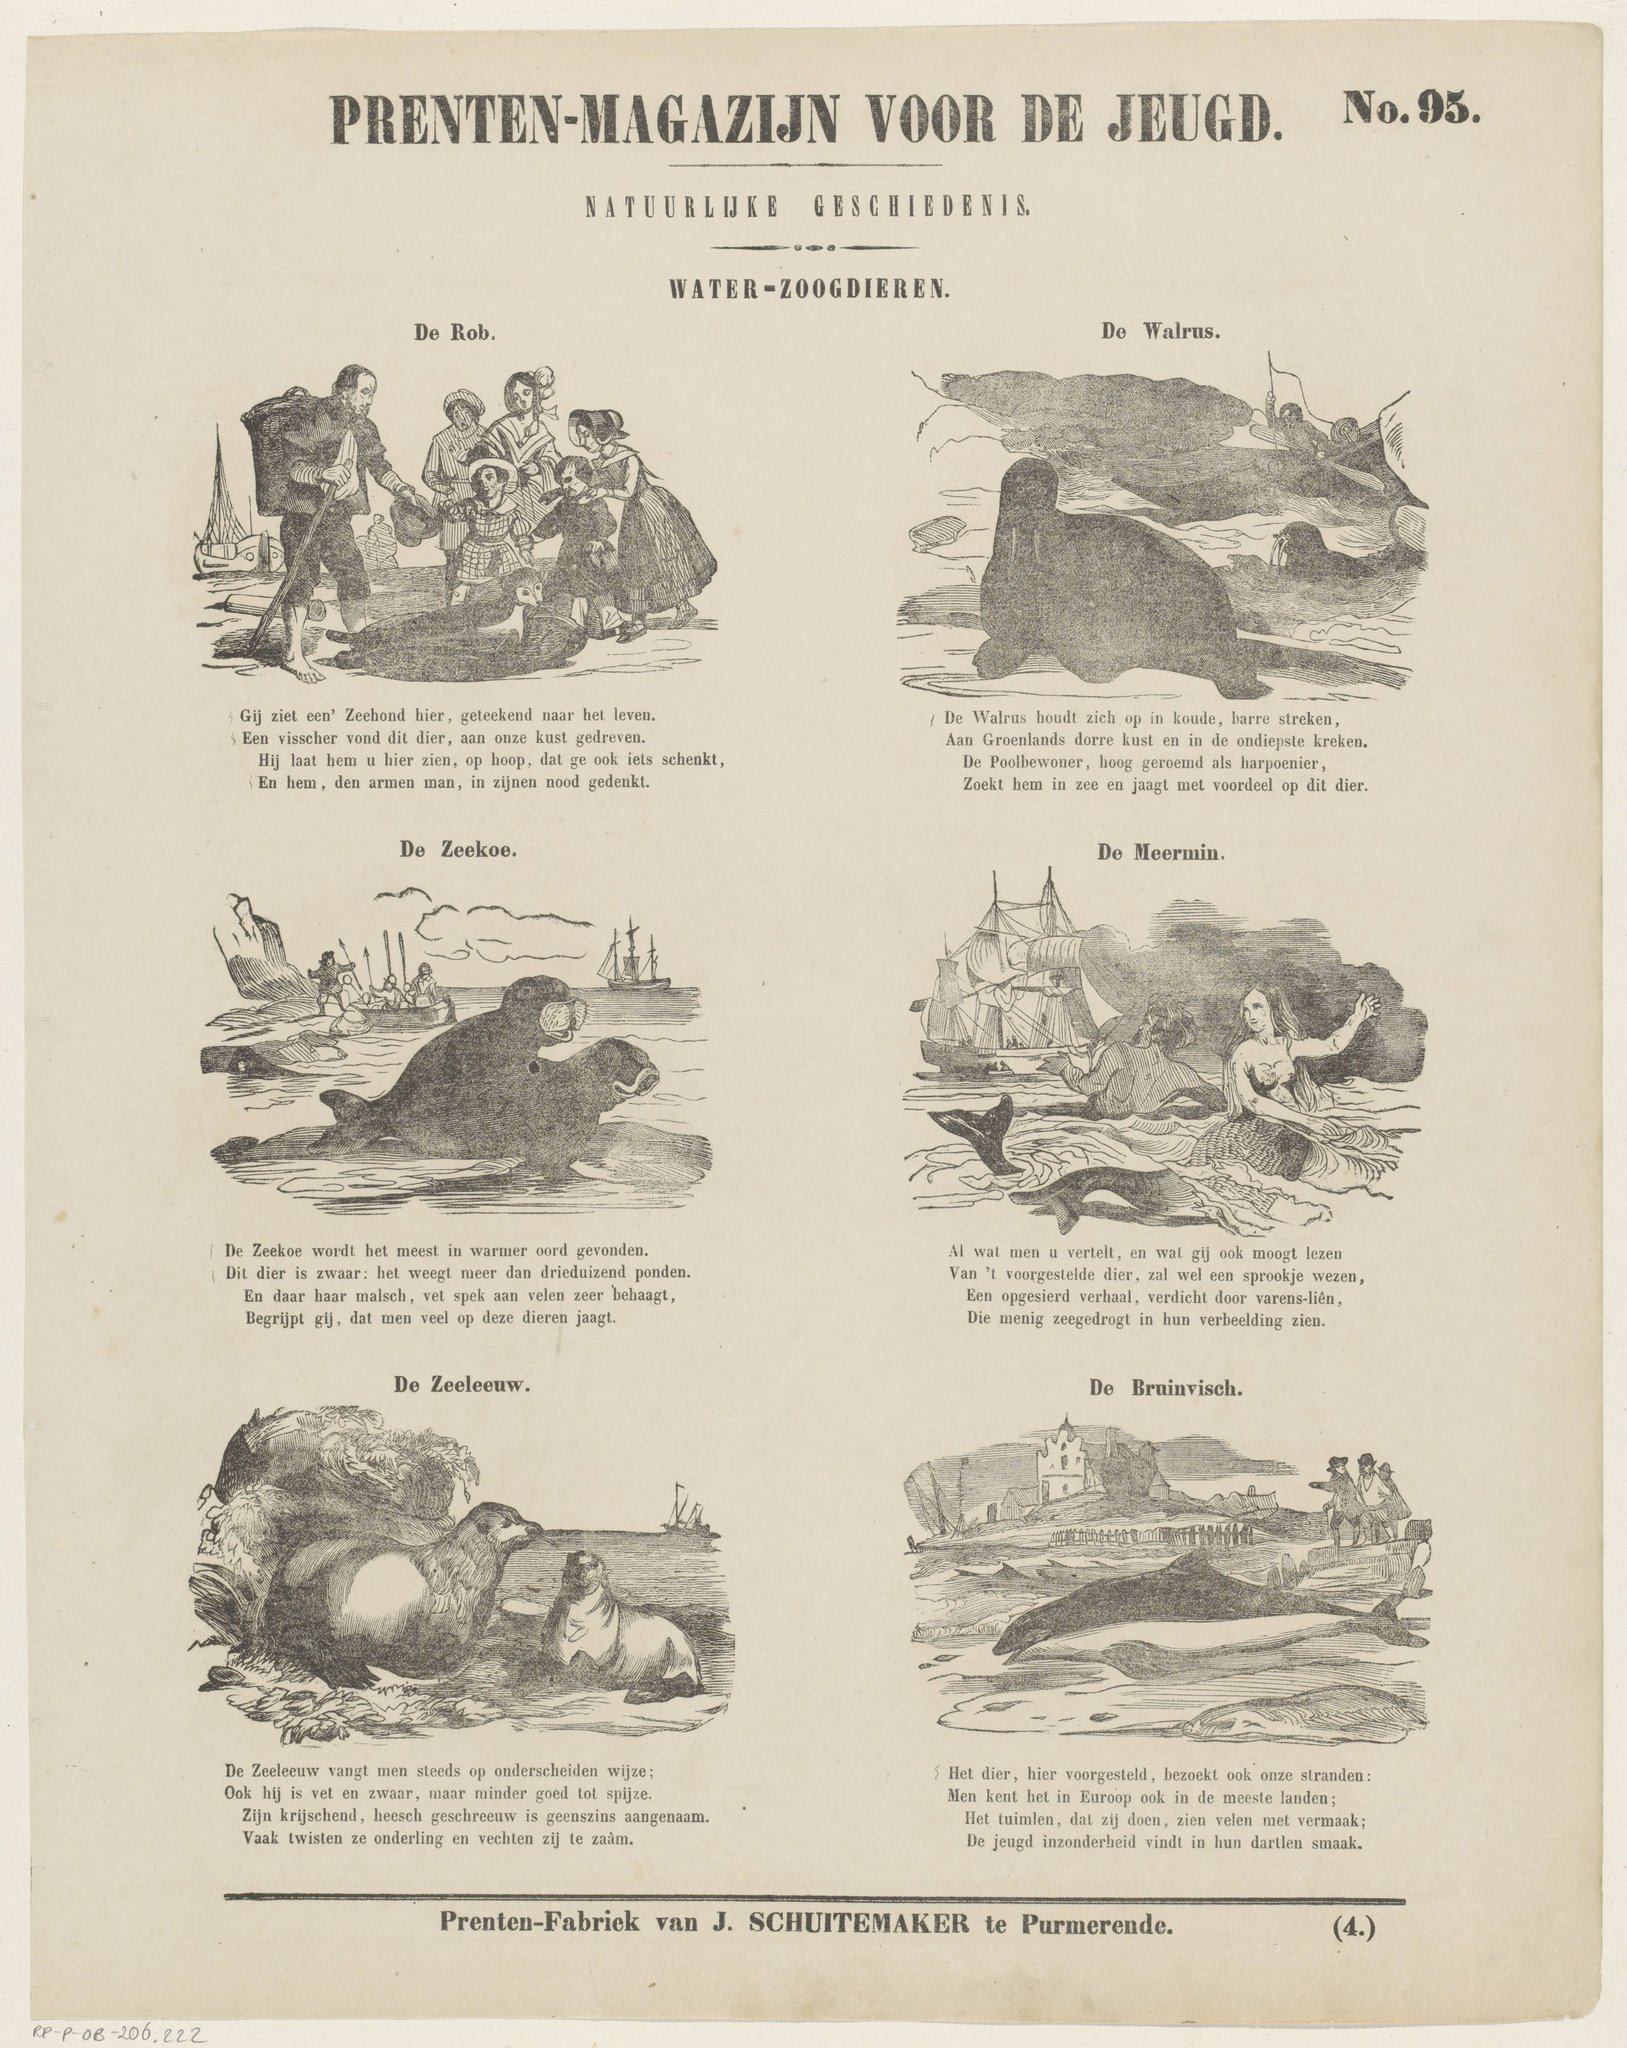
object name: popular print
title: Water-zoogdieren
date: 1850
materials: paper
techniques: letterpress printing, engraving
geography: netherlands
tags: fabulous animals ~ swimming mammals, merman, merman - aa - mermaid, siren, swimming mammals: seal, swimming mammals, swimming mammals: walrus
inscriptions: collector's mark: Lugt 2760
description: Na voltooiing van de acht jaargangen van de reeks 'Prenten-magazijn voor de jeugd' in 1850 heeft Jan Schuitemaker al deze prenten heruitgegeven en omgenummerd als nr. 1 t/m 192. De oorspronkelijke jaargang wordt telkens nog vermeld rechtsonder op de prent. Binnen de jaargangen zijn prenten van hetzelfde thema in clusters van vier achter elkaar gezet.